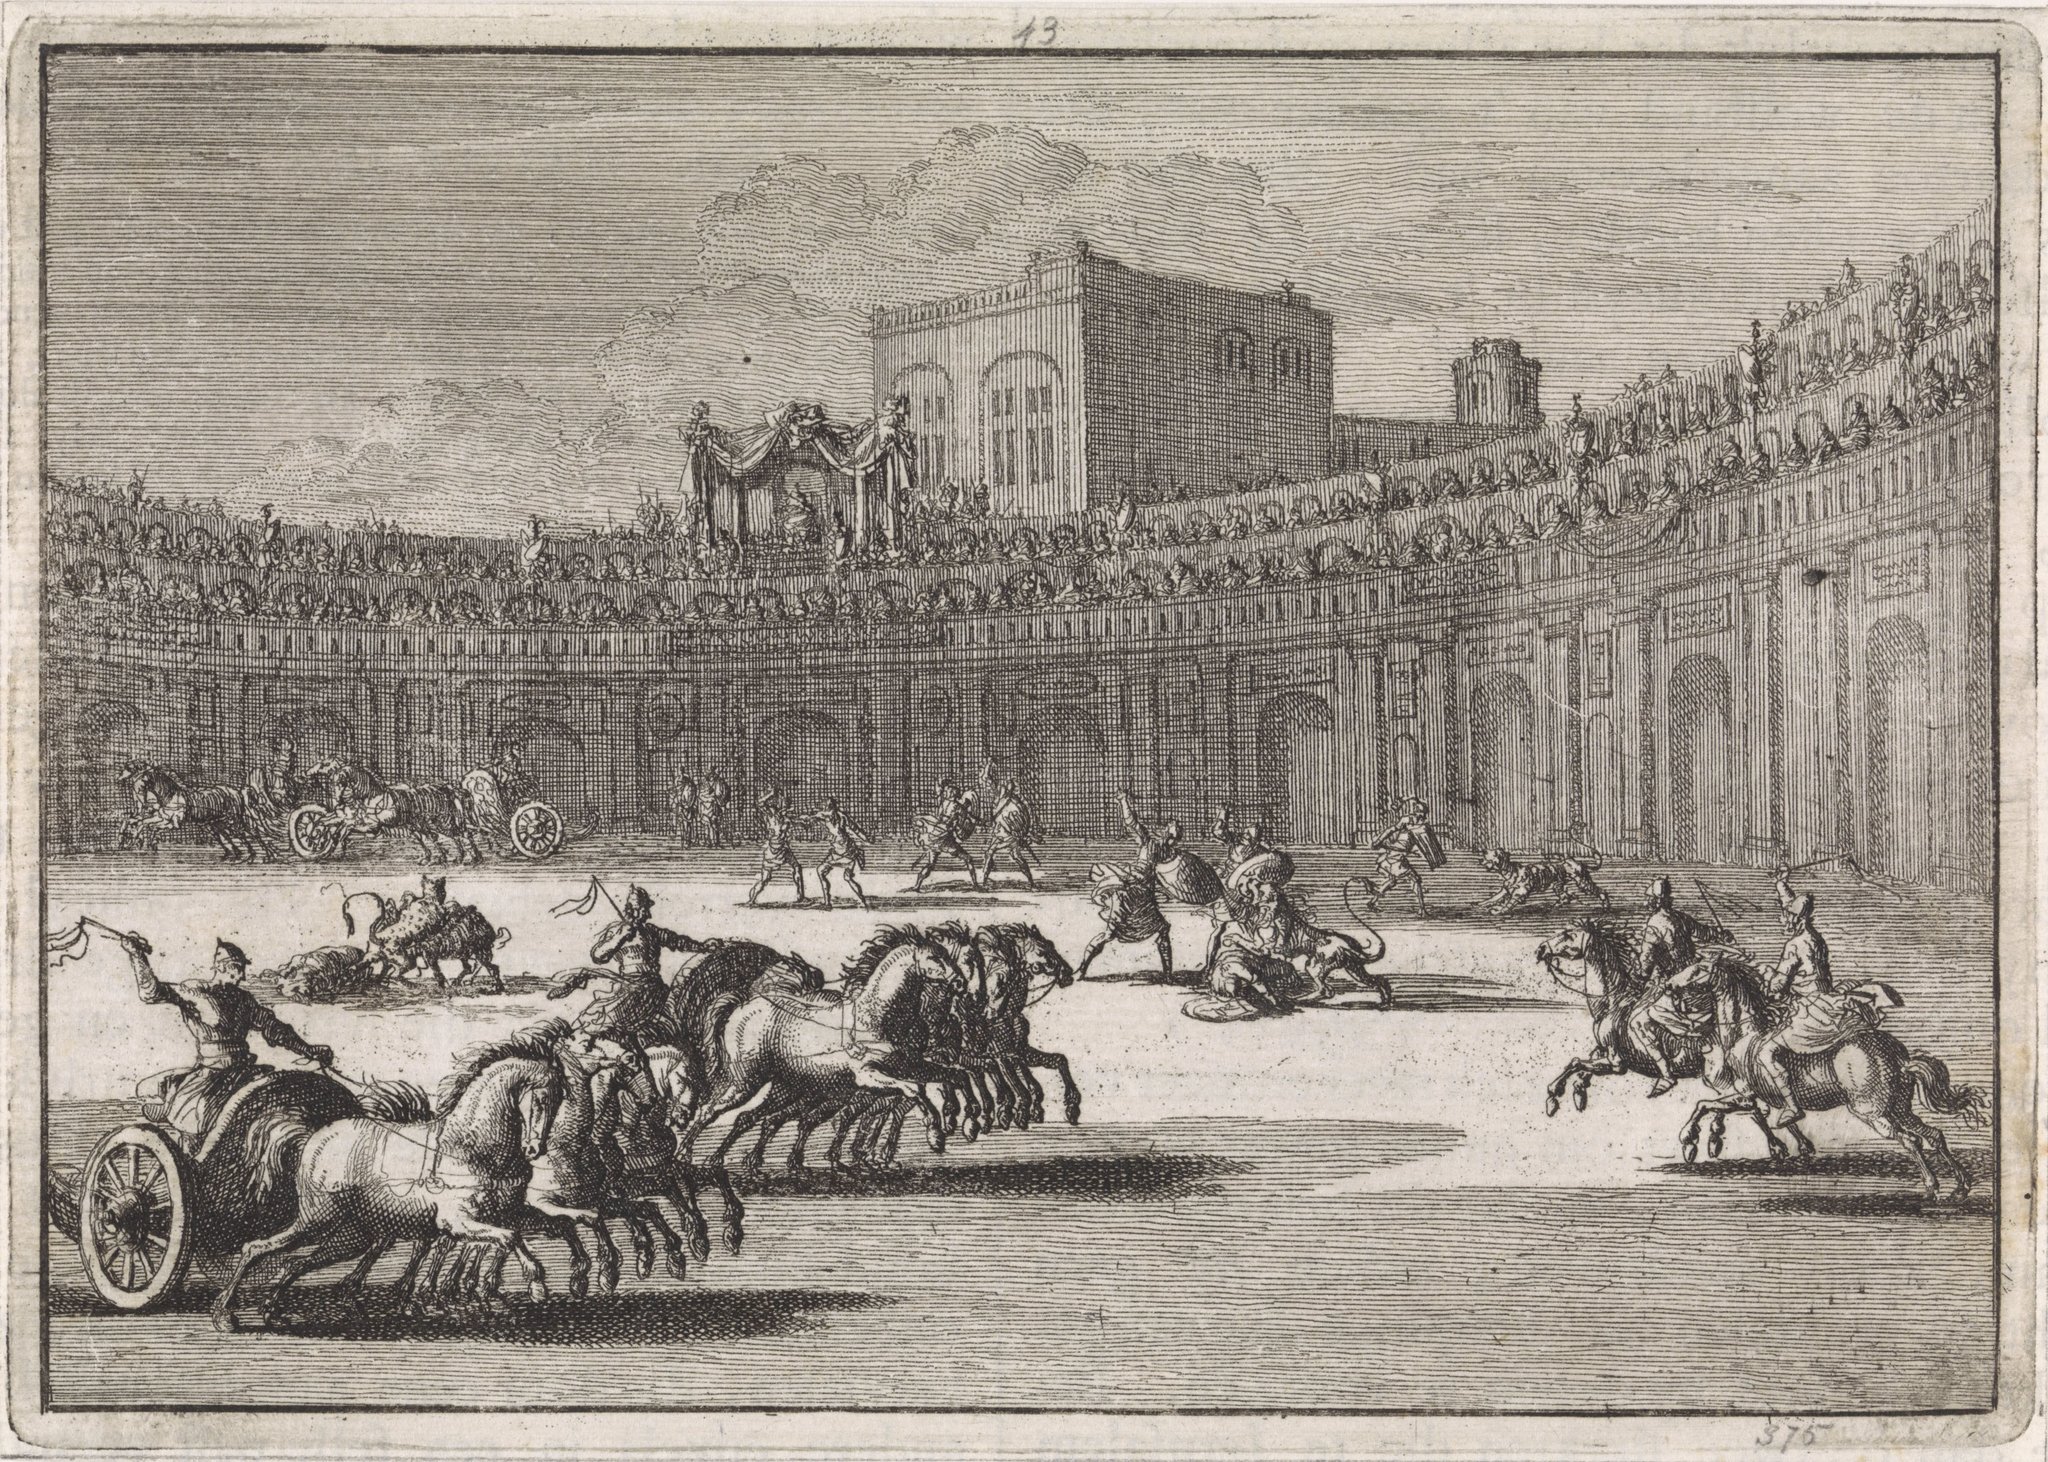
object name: print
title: Renspelen te Jeruzalem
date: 1704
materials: paper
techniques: etching, letterpress printing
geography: amsterdam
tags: wagon racing with two-wheeled vehicle, e.g.: chariot, sulky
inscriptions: collector's mark: Lugt 2228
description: Prent opgenomen in: Josephus, Flavius. Alle de Werken, 2 delen. Amsterdam: Pieter Mortier, 1704, dl. 1, p. 375.